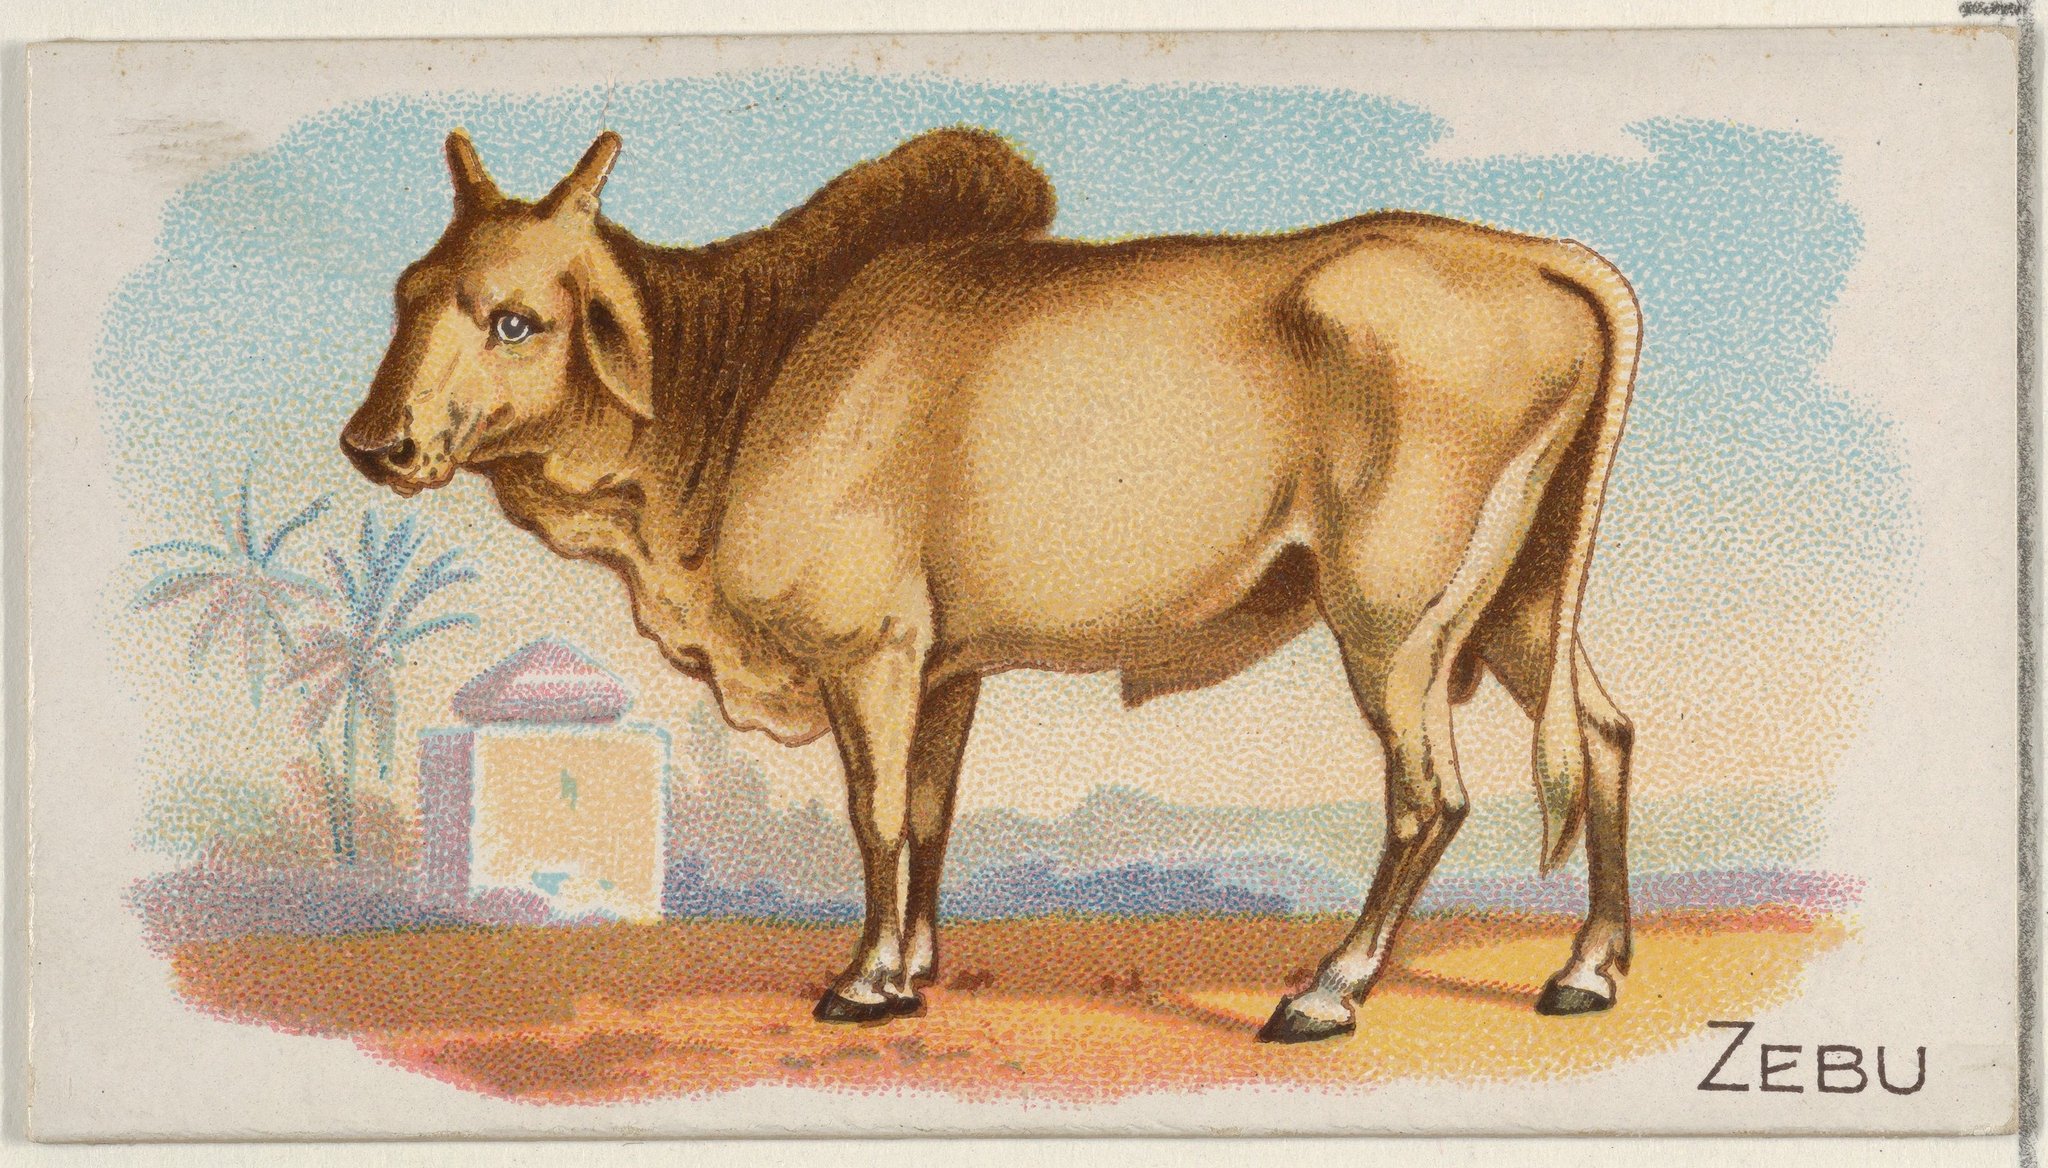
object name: print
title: Zebu, from the Quadrupeds series (N21) for Allen & Ginter Cigarettes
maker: allen & ginter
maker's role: publisher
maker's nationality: american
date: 1890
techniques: color lithograph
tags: animals